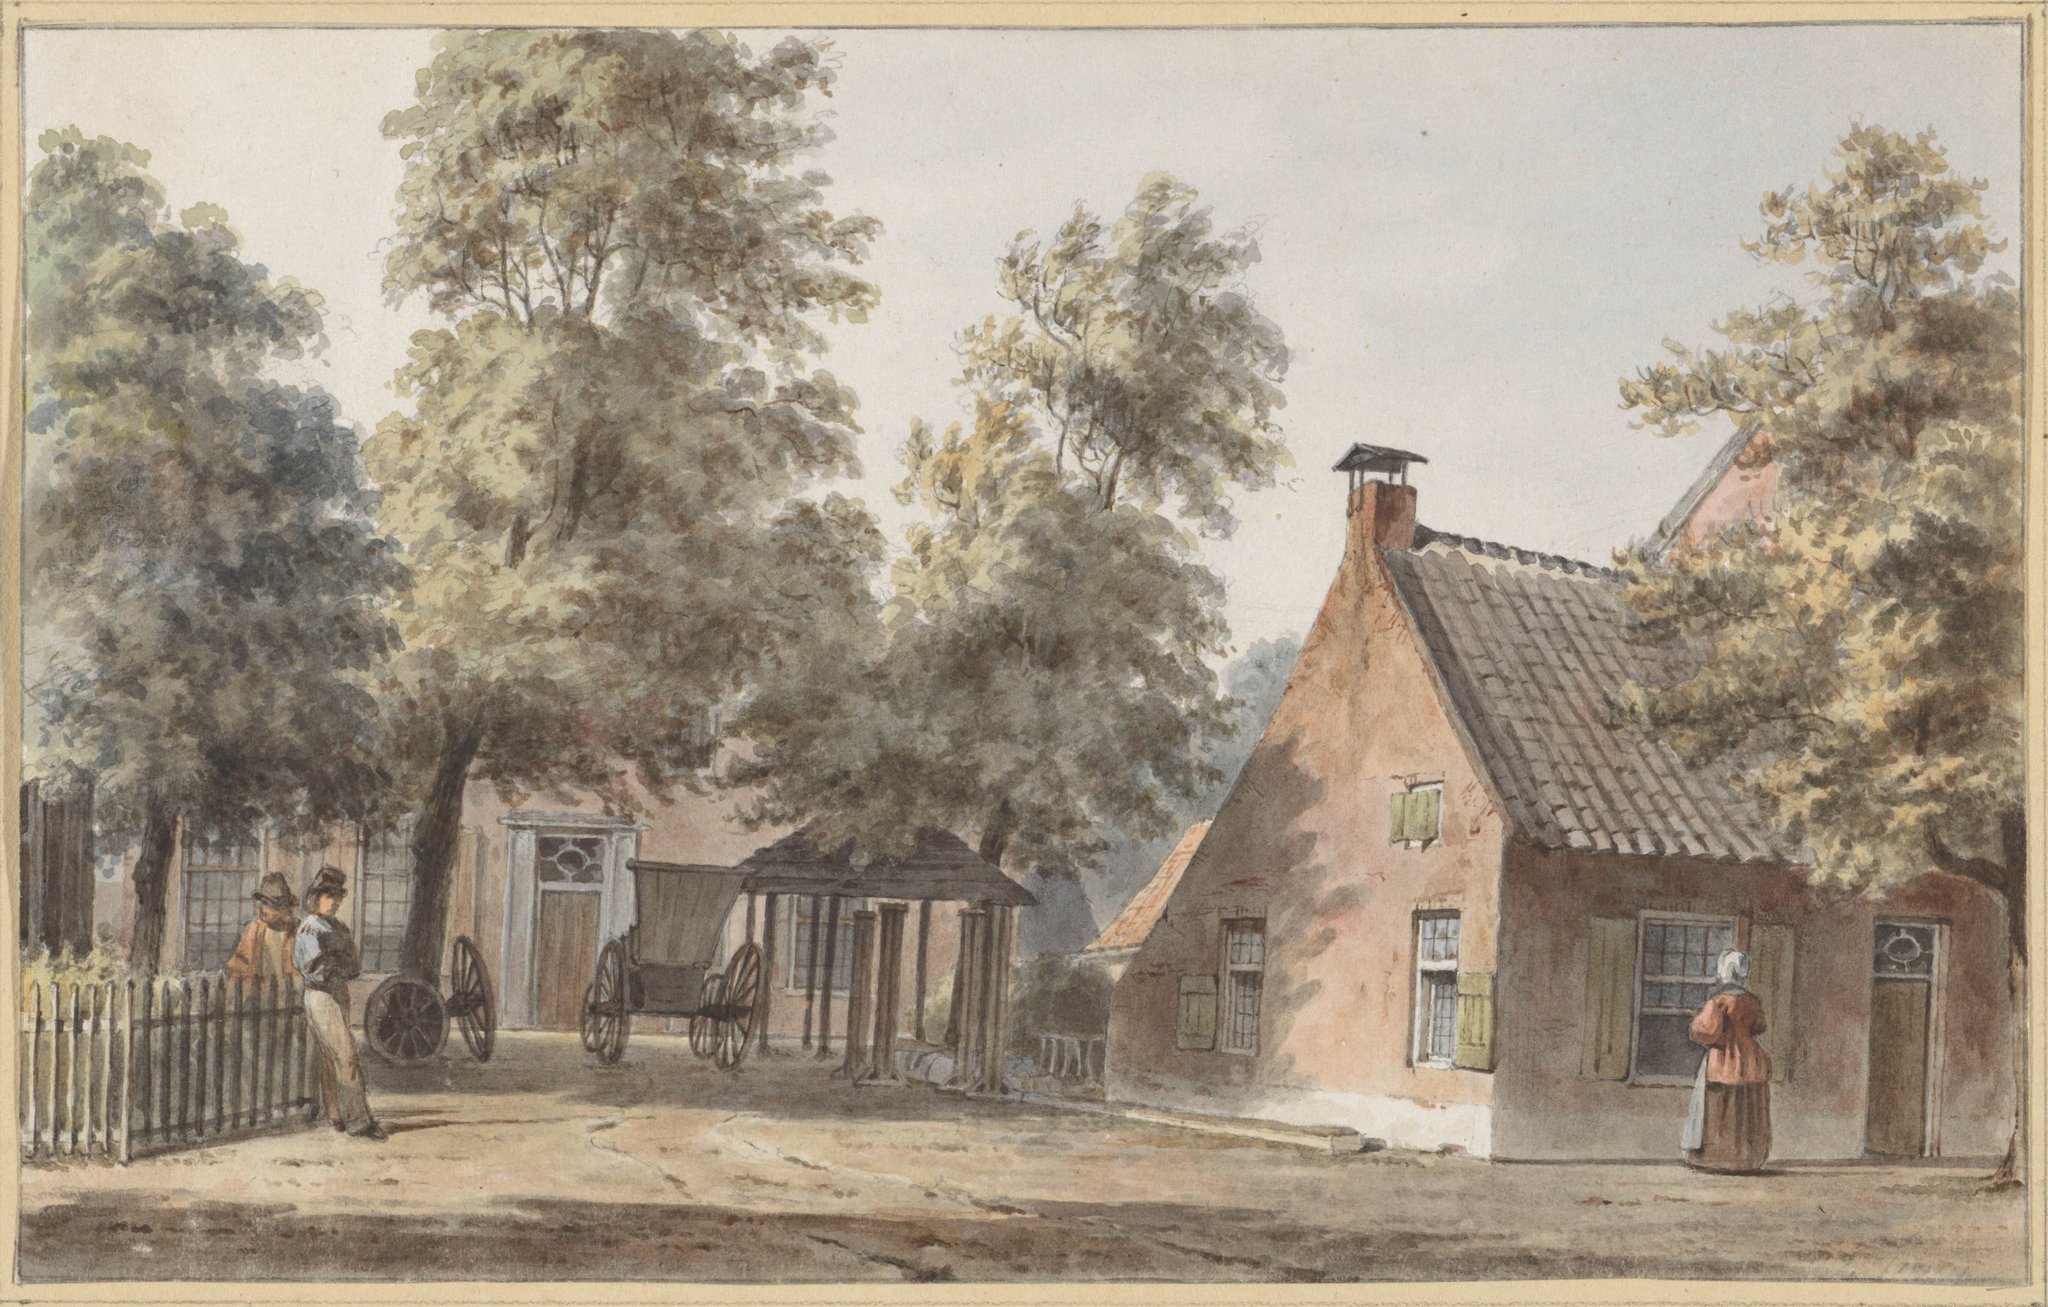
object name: watercolor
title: Dorpsgezicht met links twee mannen leunend tegen een hekwerk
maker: hendrik abraham klinkhamer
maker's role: draughtsman, painter, print maker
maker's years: 1810-1872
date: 1820-1872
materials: paper, pencil, watercolor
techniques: brush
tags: prospect of village, silhouette of village